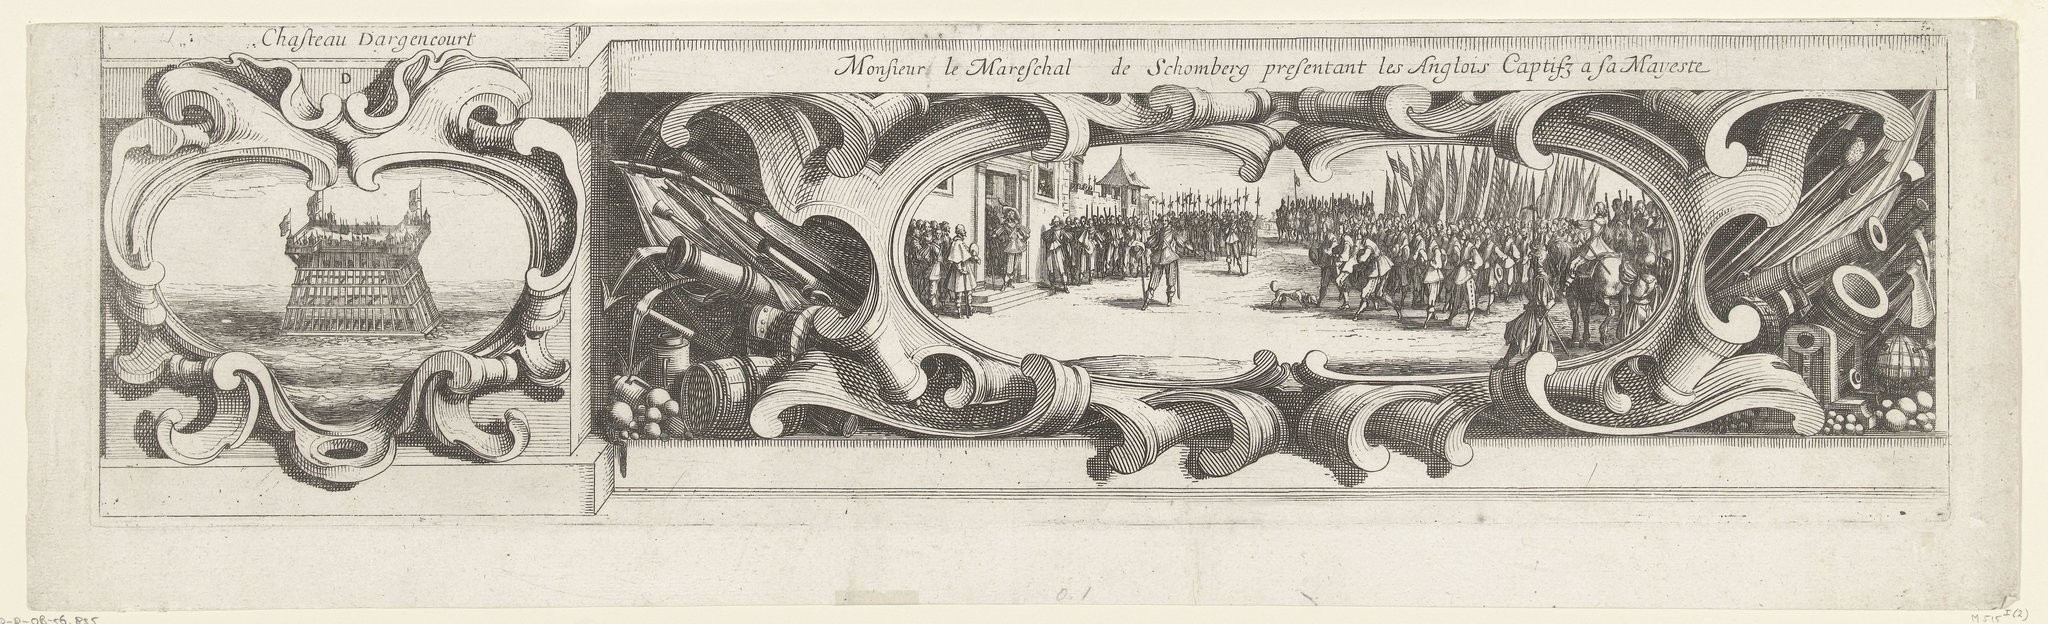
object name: print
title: Beleg van La Rochelle, september 1627-oktober 1628 (randwerk, deel linksonder)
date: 1628-1631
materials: paper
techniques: engraving, etching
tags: paris, armand-jean du plessis hertog van richelieu, lodewijk xiii (koning van frankrijk), ornament ~ cartouche, prisoner of war (after the battle), temporary fortifications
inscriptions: collector's mark: Lugt 240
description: Zestiende deel (randwerk, deel linksonder) van een prent van het beleg van het hugenotenbolwerk La Rochelle in de jaren 1627 en 1628, dat werd uitgevoerd in opdracht van de Franse koning door het Franse leger onder aanvoering van kardinaal Richelieu. Op dit blad links een voorstelling van een houten toren in zee en midden/rechts een voorstelling (omgeven door militaire attributen) van Engelse krijgsgevangenen die voor koning Lodewijk XIII worden geleid.